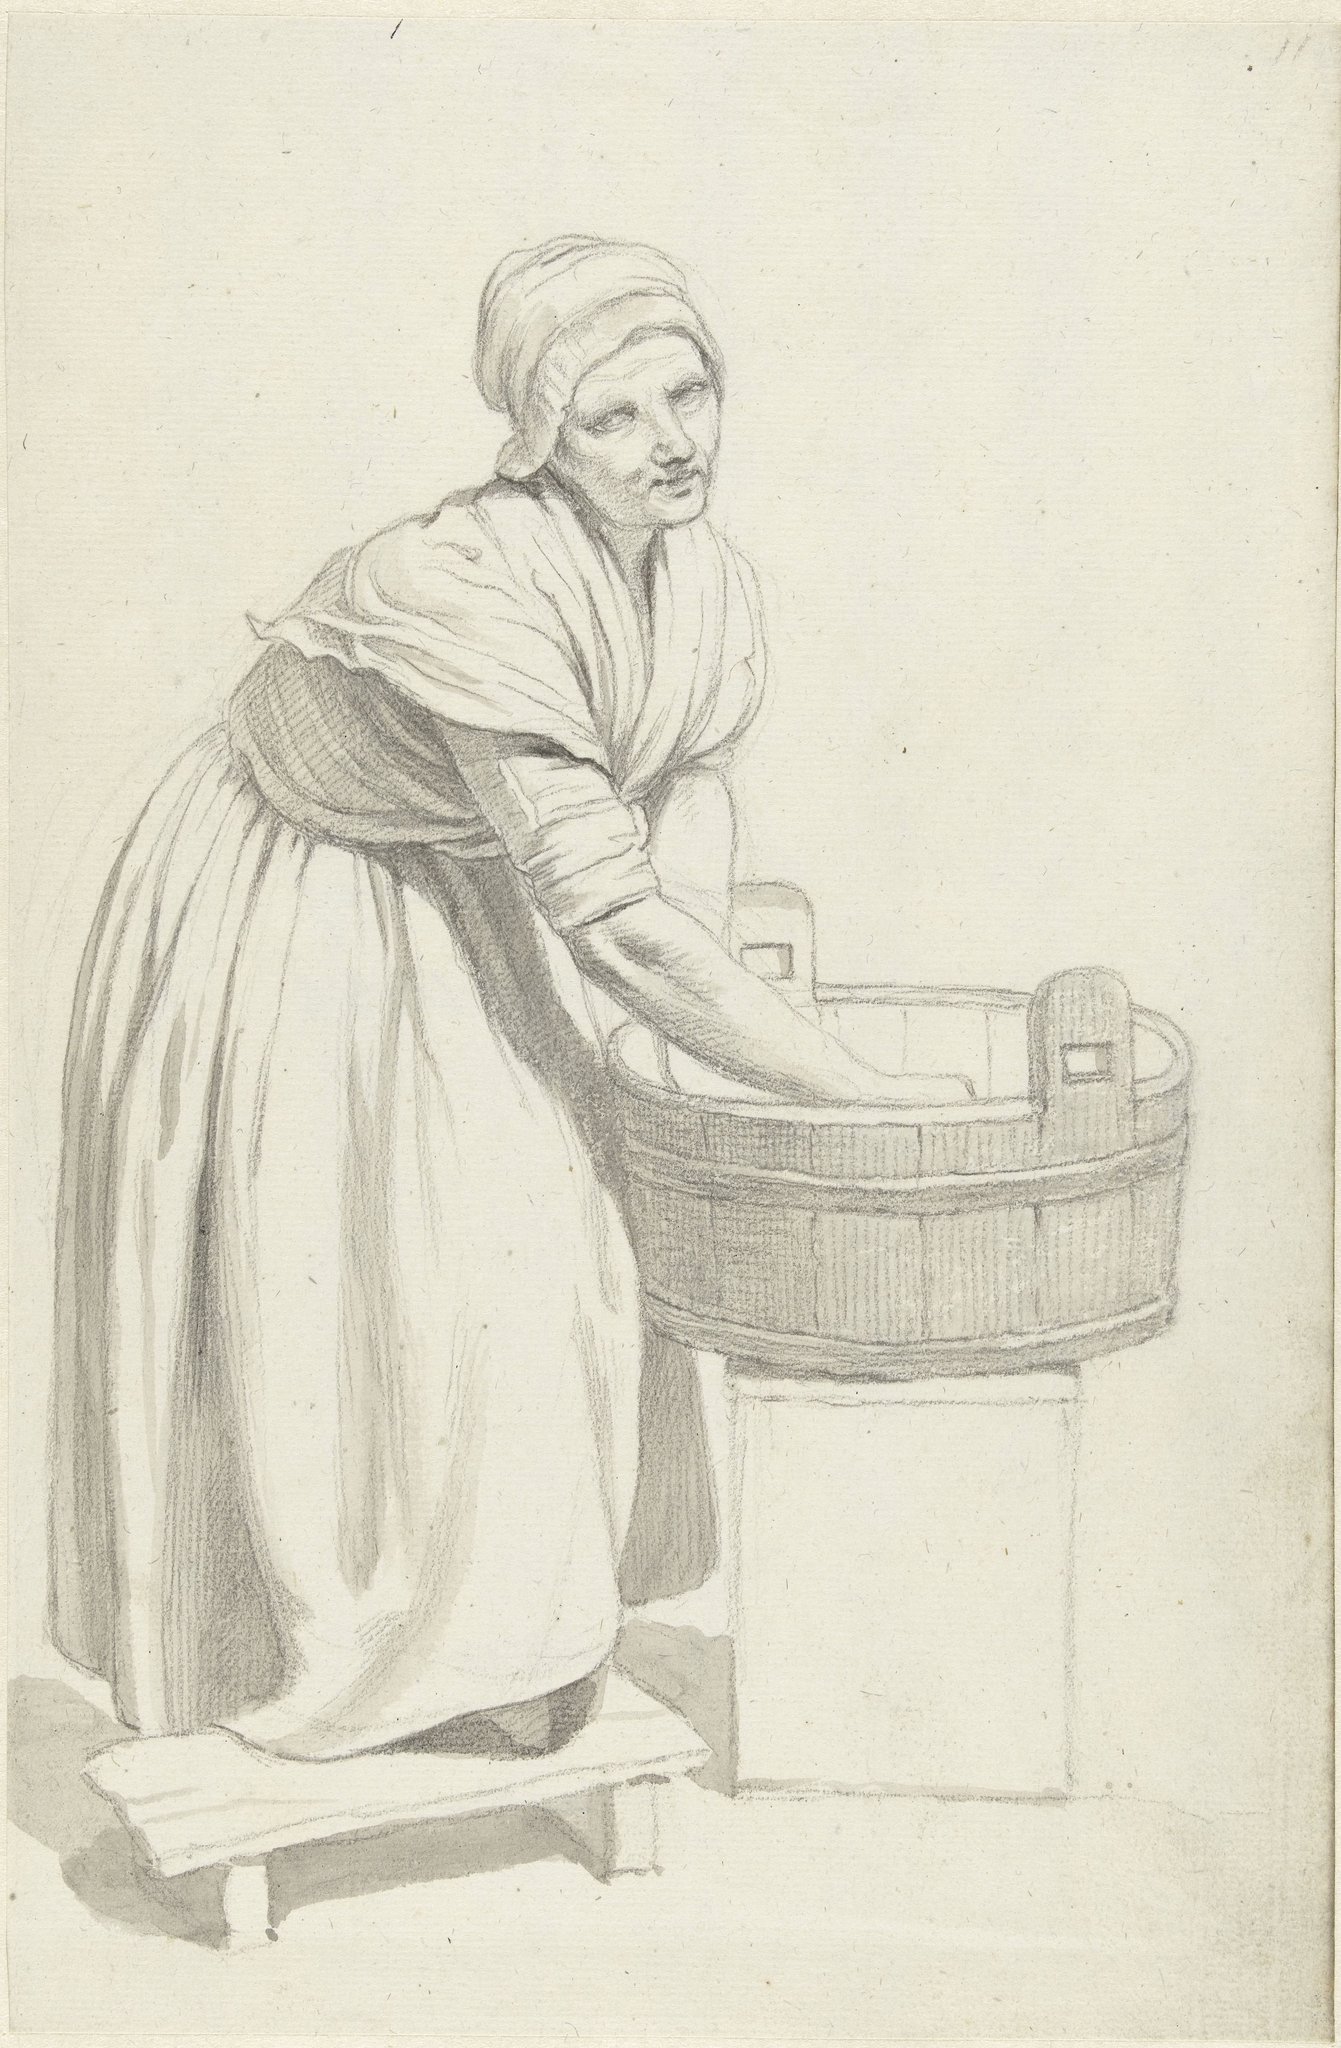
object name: drawing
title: Vrouw aan wastobbe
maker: jacob ernst marcus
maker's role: draughtsman, print maker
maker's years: 1774-1826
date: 1784-1826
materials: chalk, paper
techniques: brush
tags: laundering